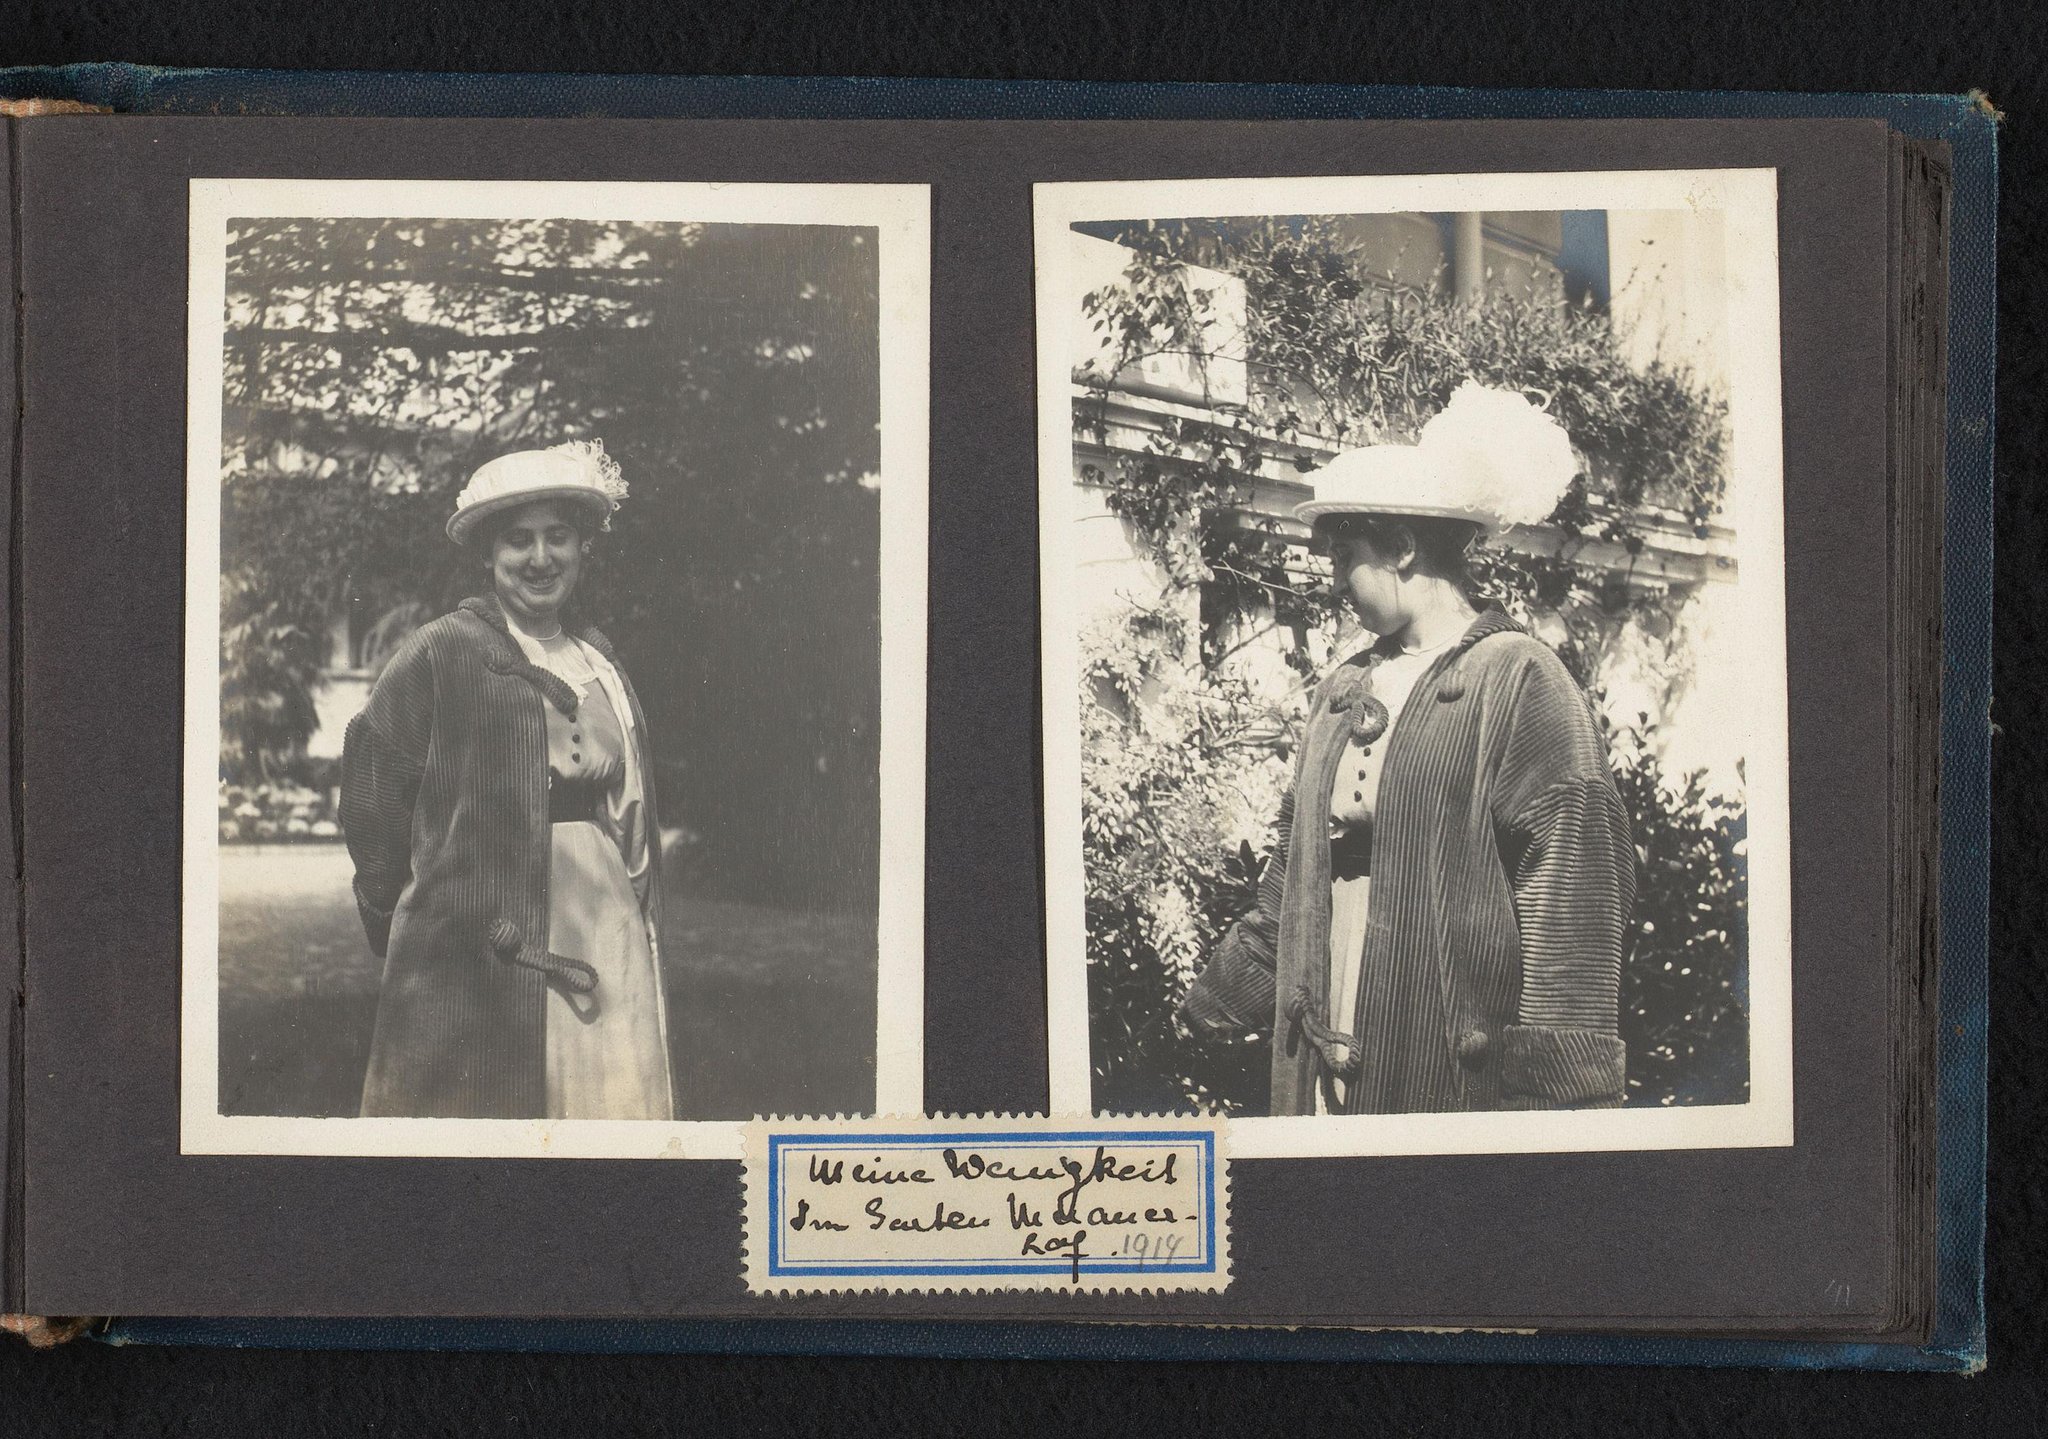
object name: album leaf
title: Else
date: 1914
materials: paper, photographic support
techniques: gelatin silver print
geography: germany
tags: else wachenheimer-moos, historical persons - bb - woman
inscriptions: inscription: ‘Meine Weinigkeit / Im Garten ...hof. 1914’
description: Albumblad met twee foto's van Else Moos in de tuin. Onderdeel van het fotoalbum van Else Wachenheimer-Moos en haar broers Arthur en Willy Moos en anderen in de periode 1913-1918.